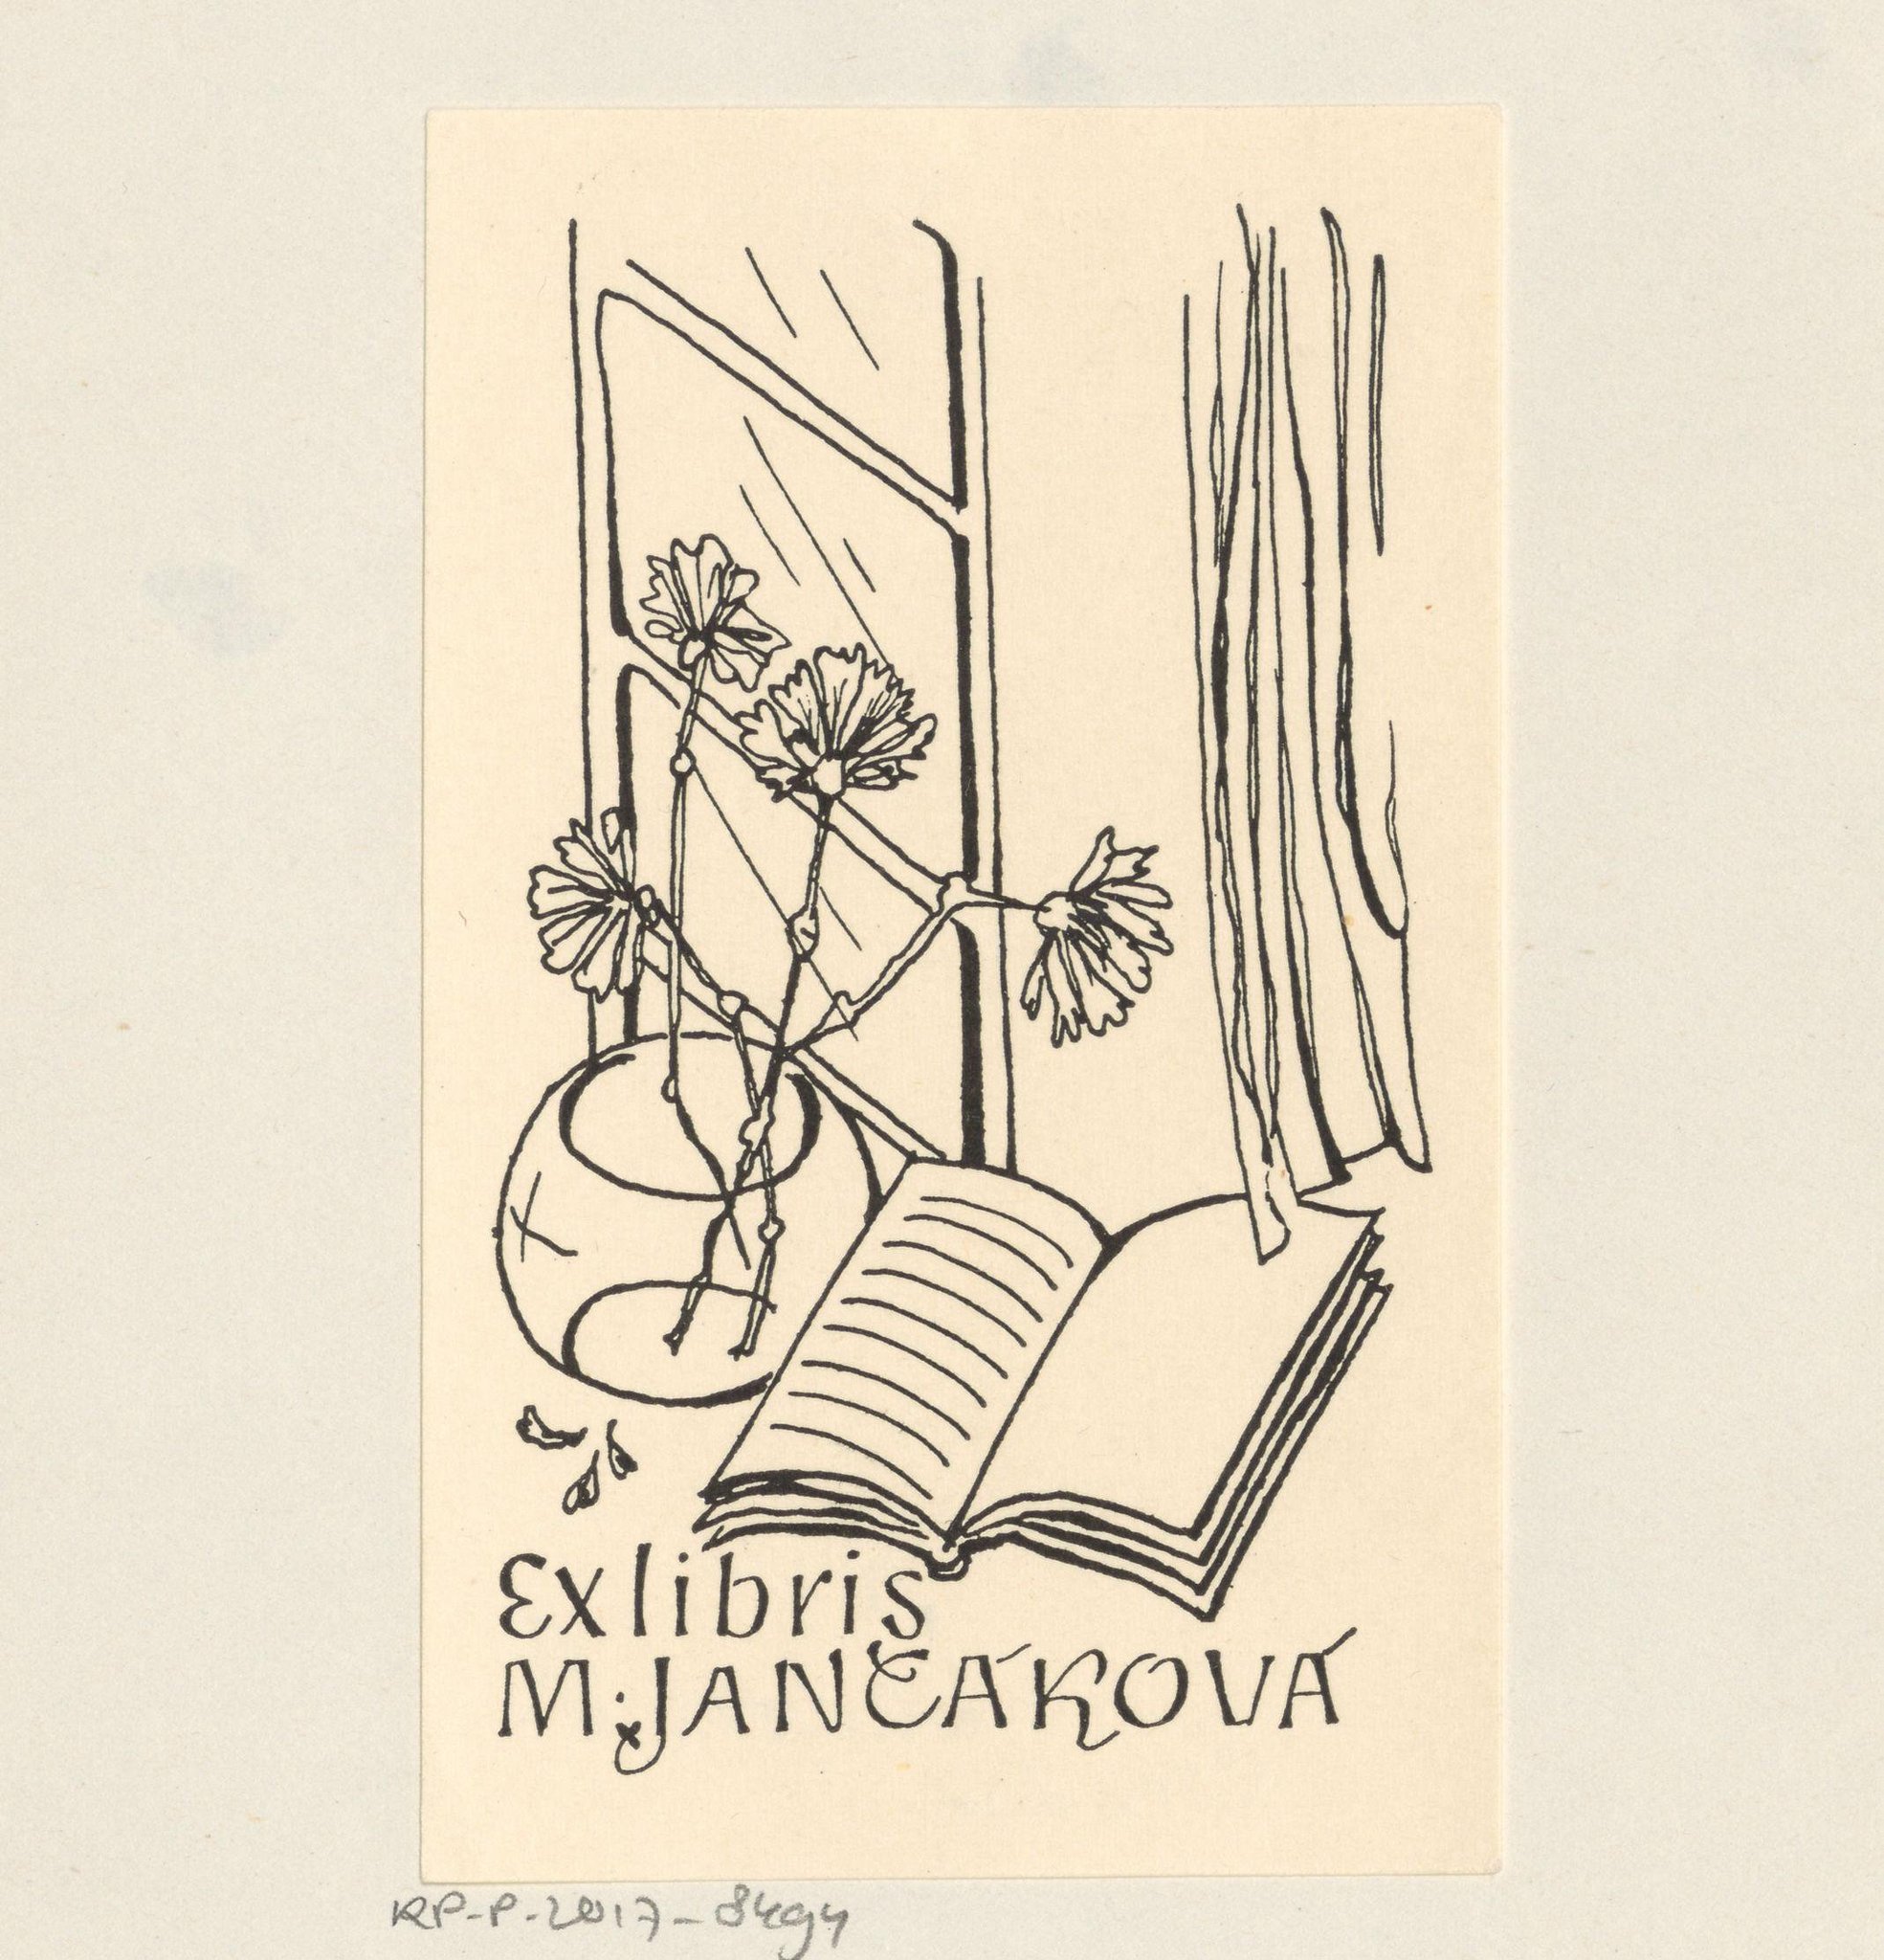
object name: bookplate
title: Ex libris van Máňa Jančáková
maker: Anonymous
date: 1900-1999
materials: paper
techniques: printing block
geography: czech republic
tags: cut flowers; nosegay, bunch of flowers, standing figure - aa - female human figure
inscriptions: inscription: ‘Ladorz A. [?]’